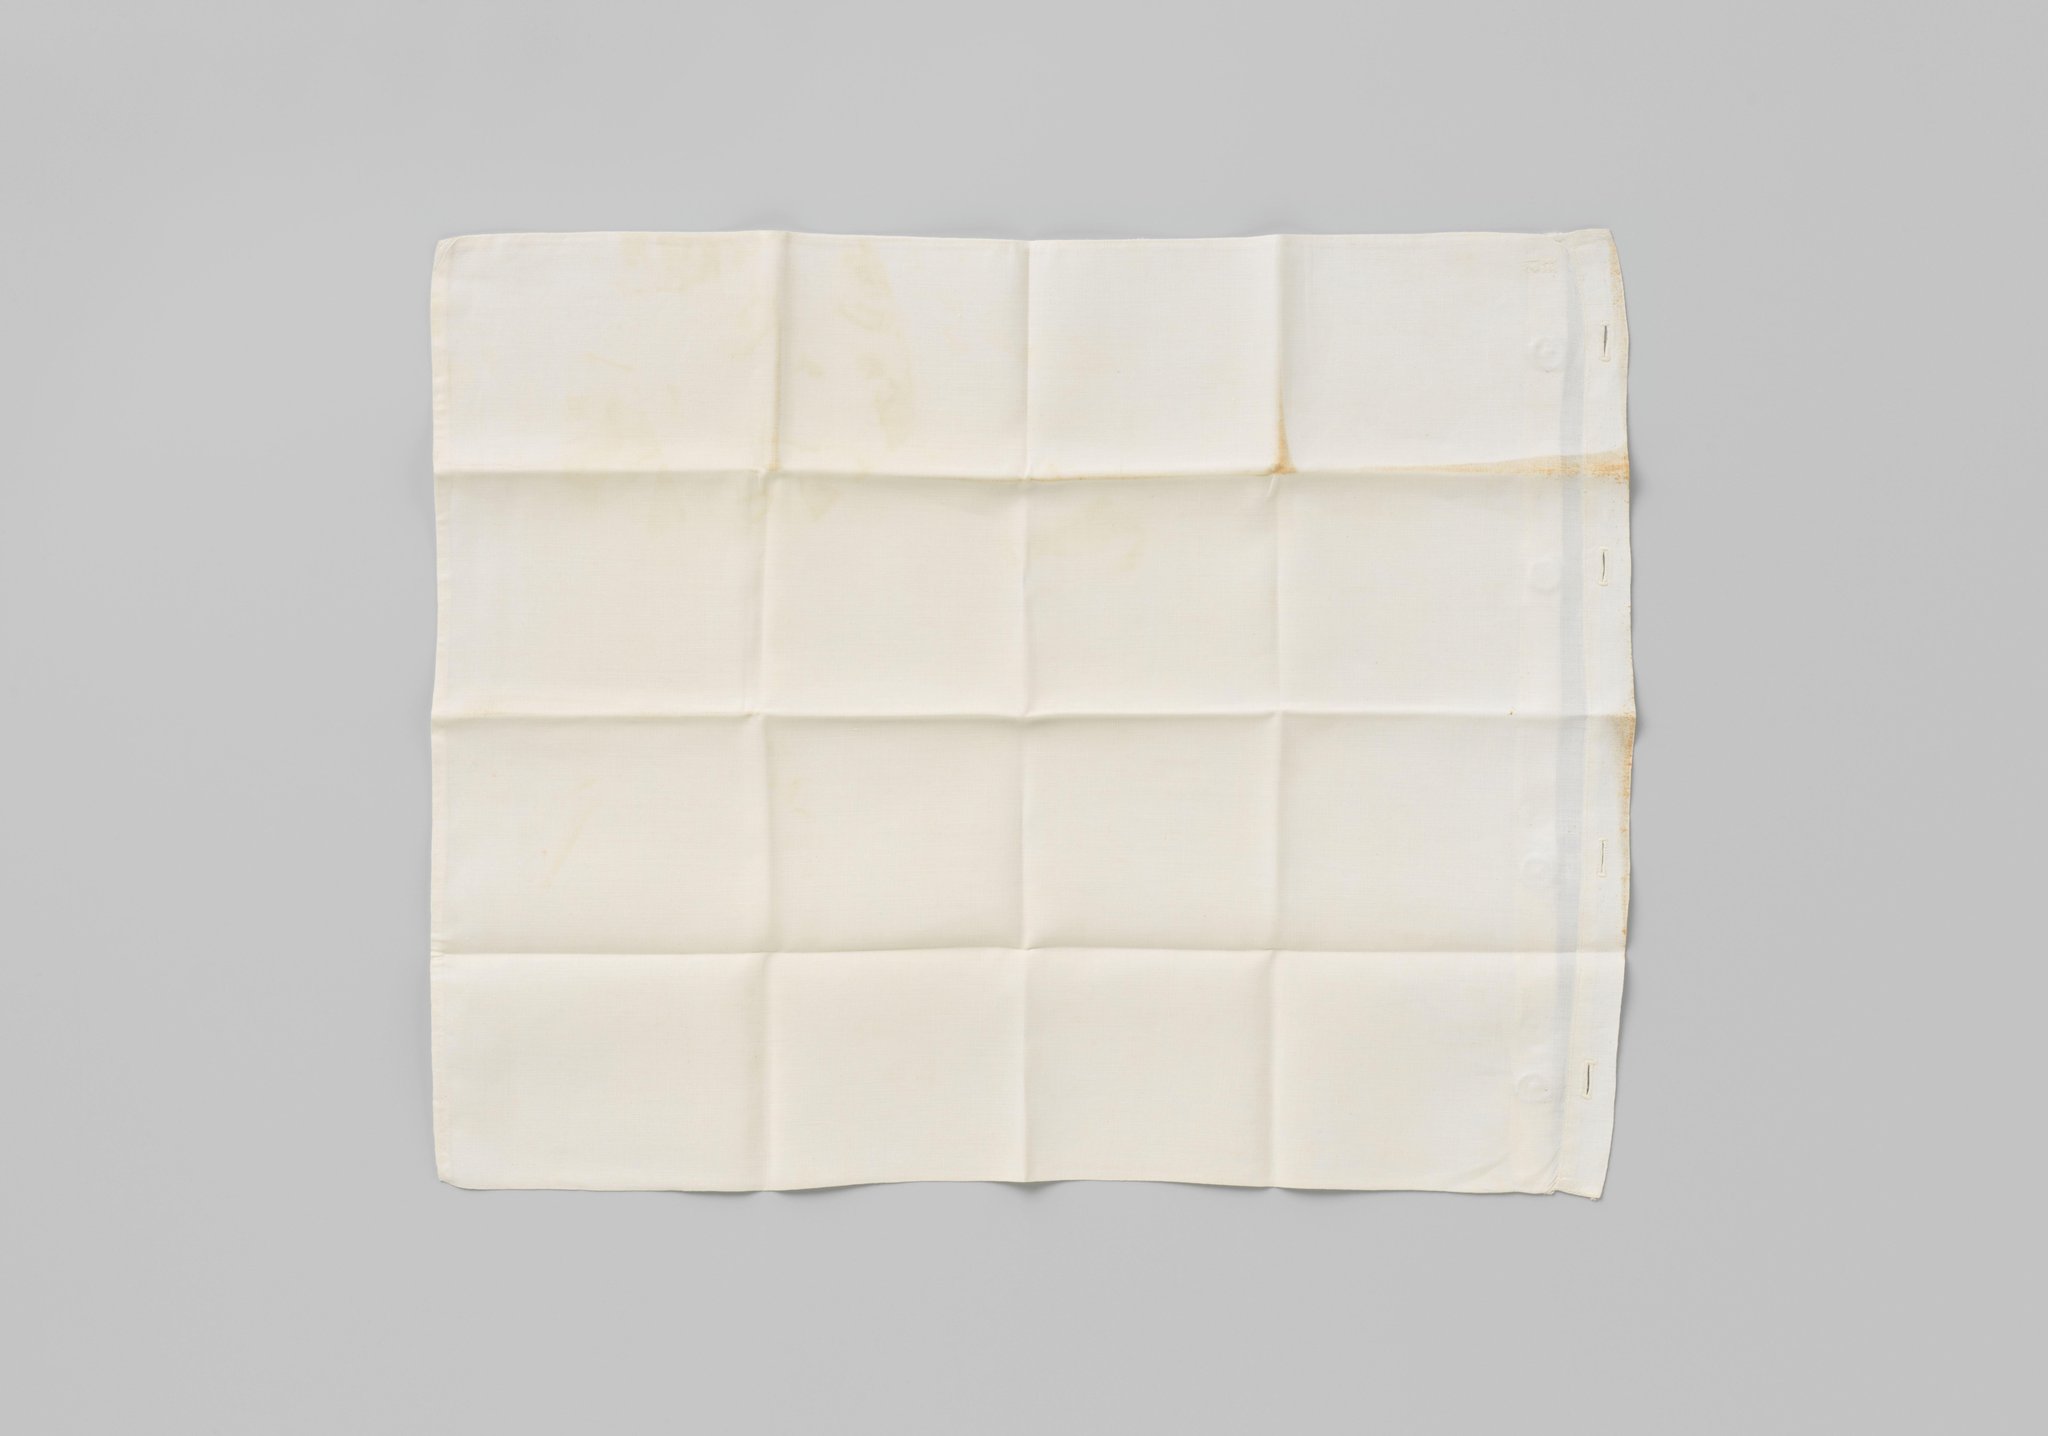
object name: lendensloop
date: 1875-1900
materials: linen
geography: northern netherlands